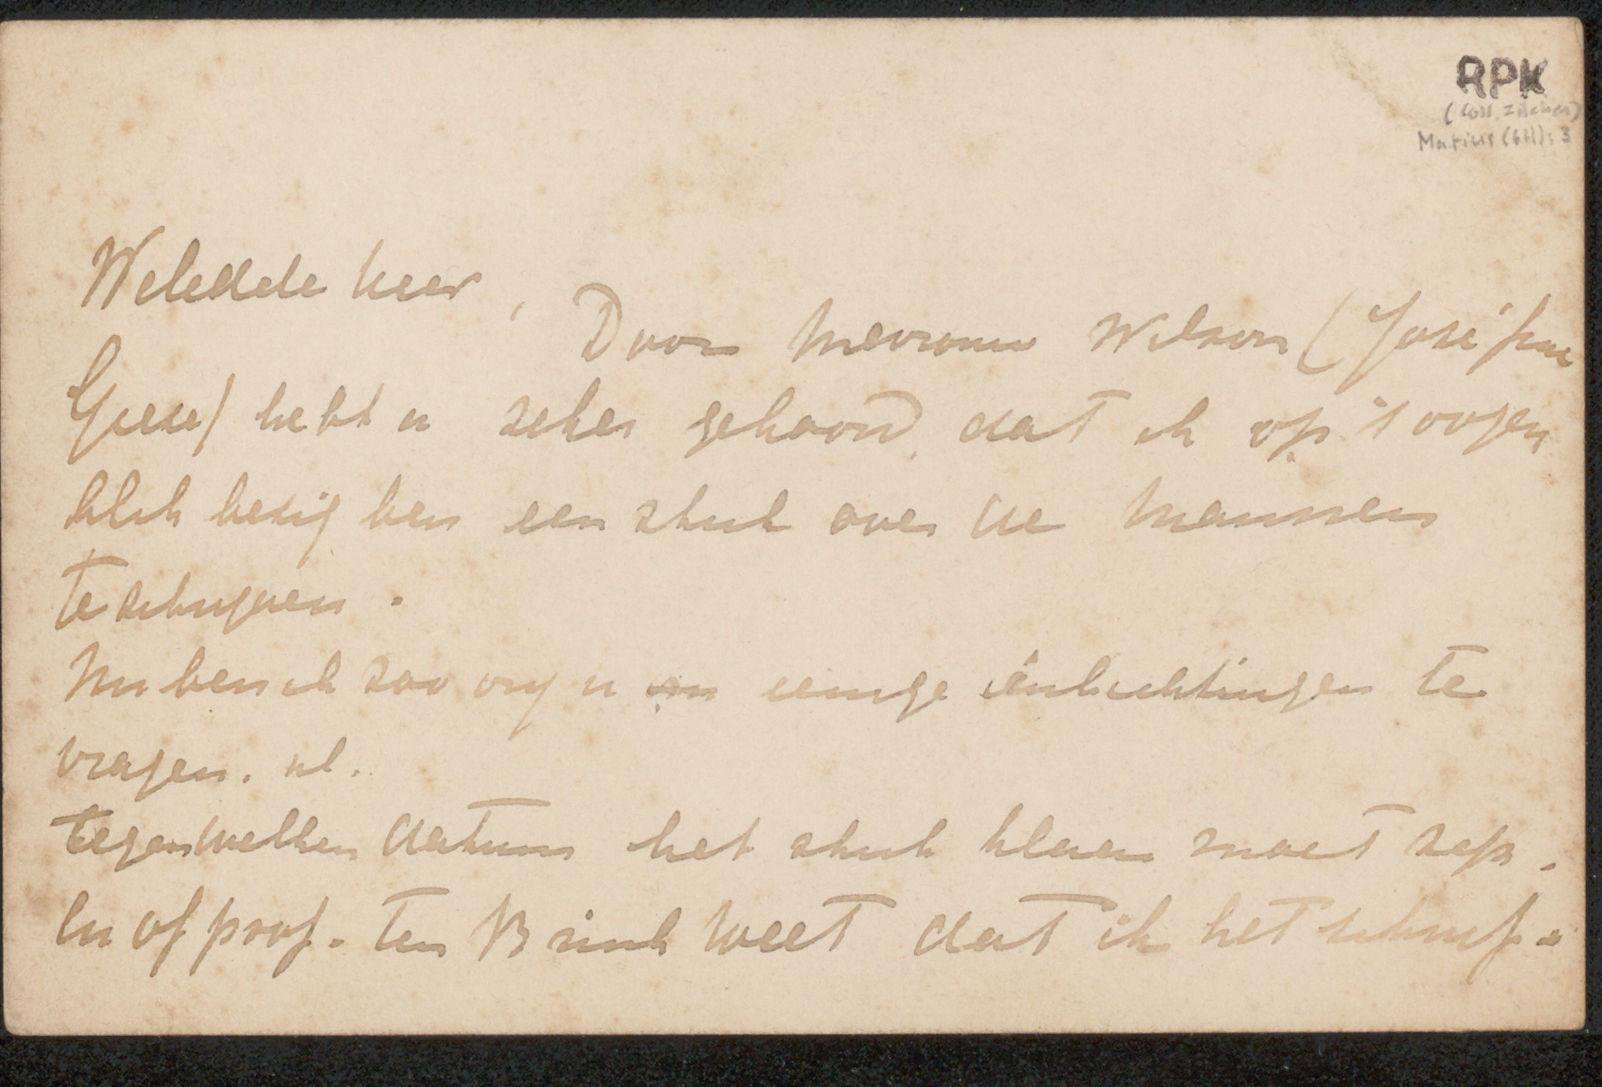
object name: letter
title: Brief aan Philip Zilcken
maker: grada hermina marius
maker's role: painter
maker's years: 1854-1919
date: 1864-1919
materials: cardboard, ink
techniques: pen, writing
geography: the hague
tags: the hague, painter, print maker, draughtsman, jacob maris, leiden, jan ten brink (1834-1901), philip zilcken, drawing, the graphic arts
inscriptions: collector's mark: ‘RPK’